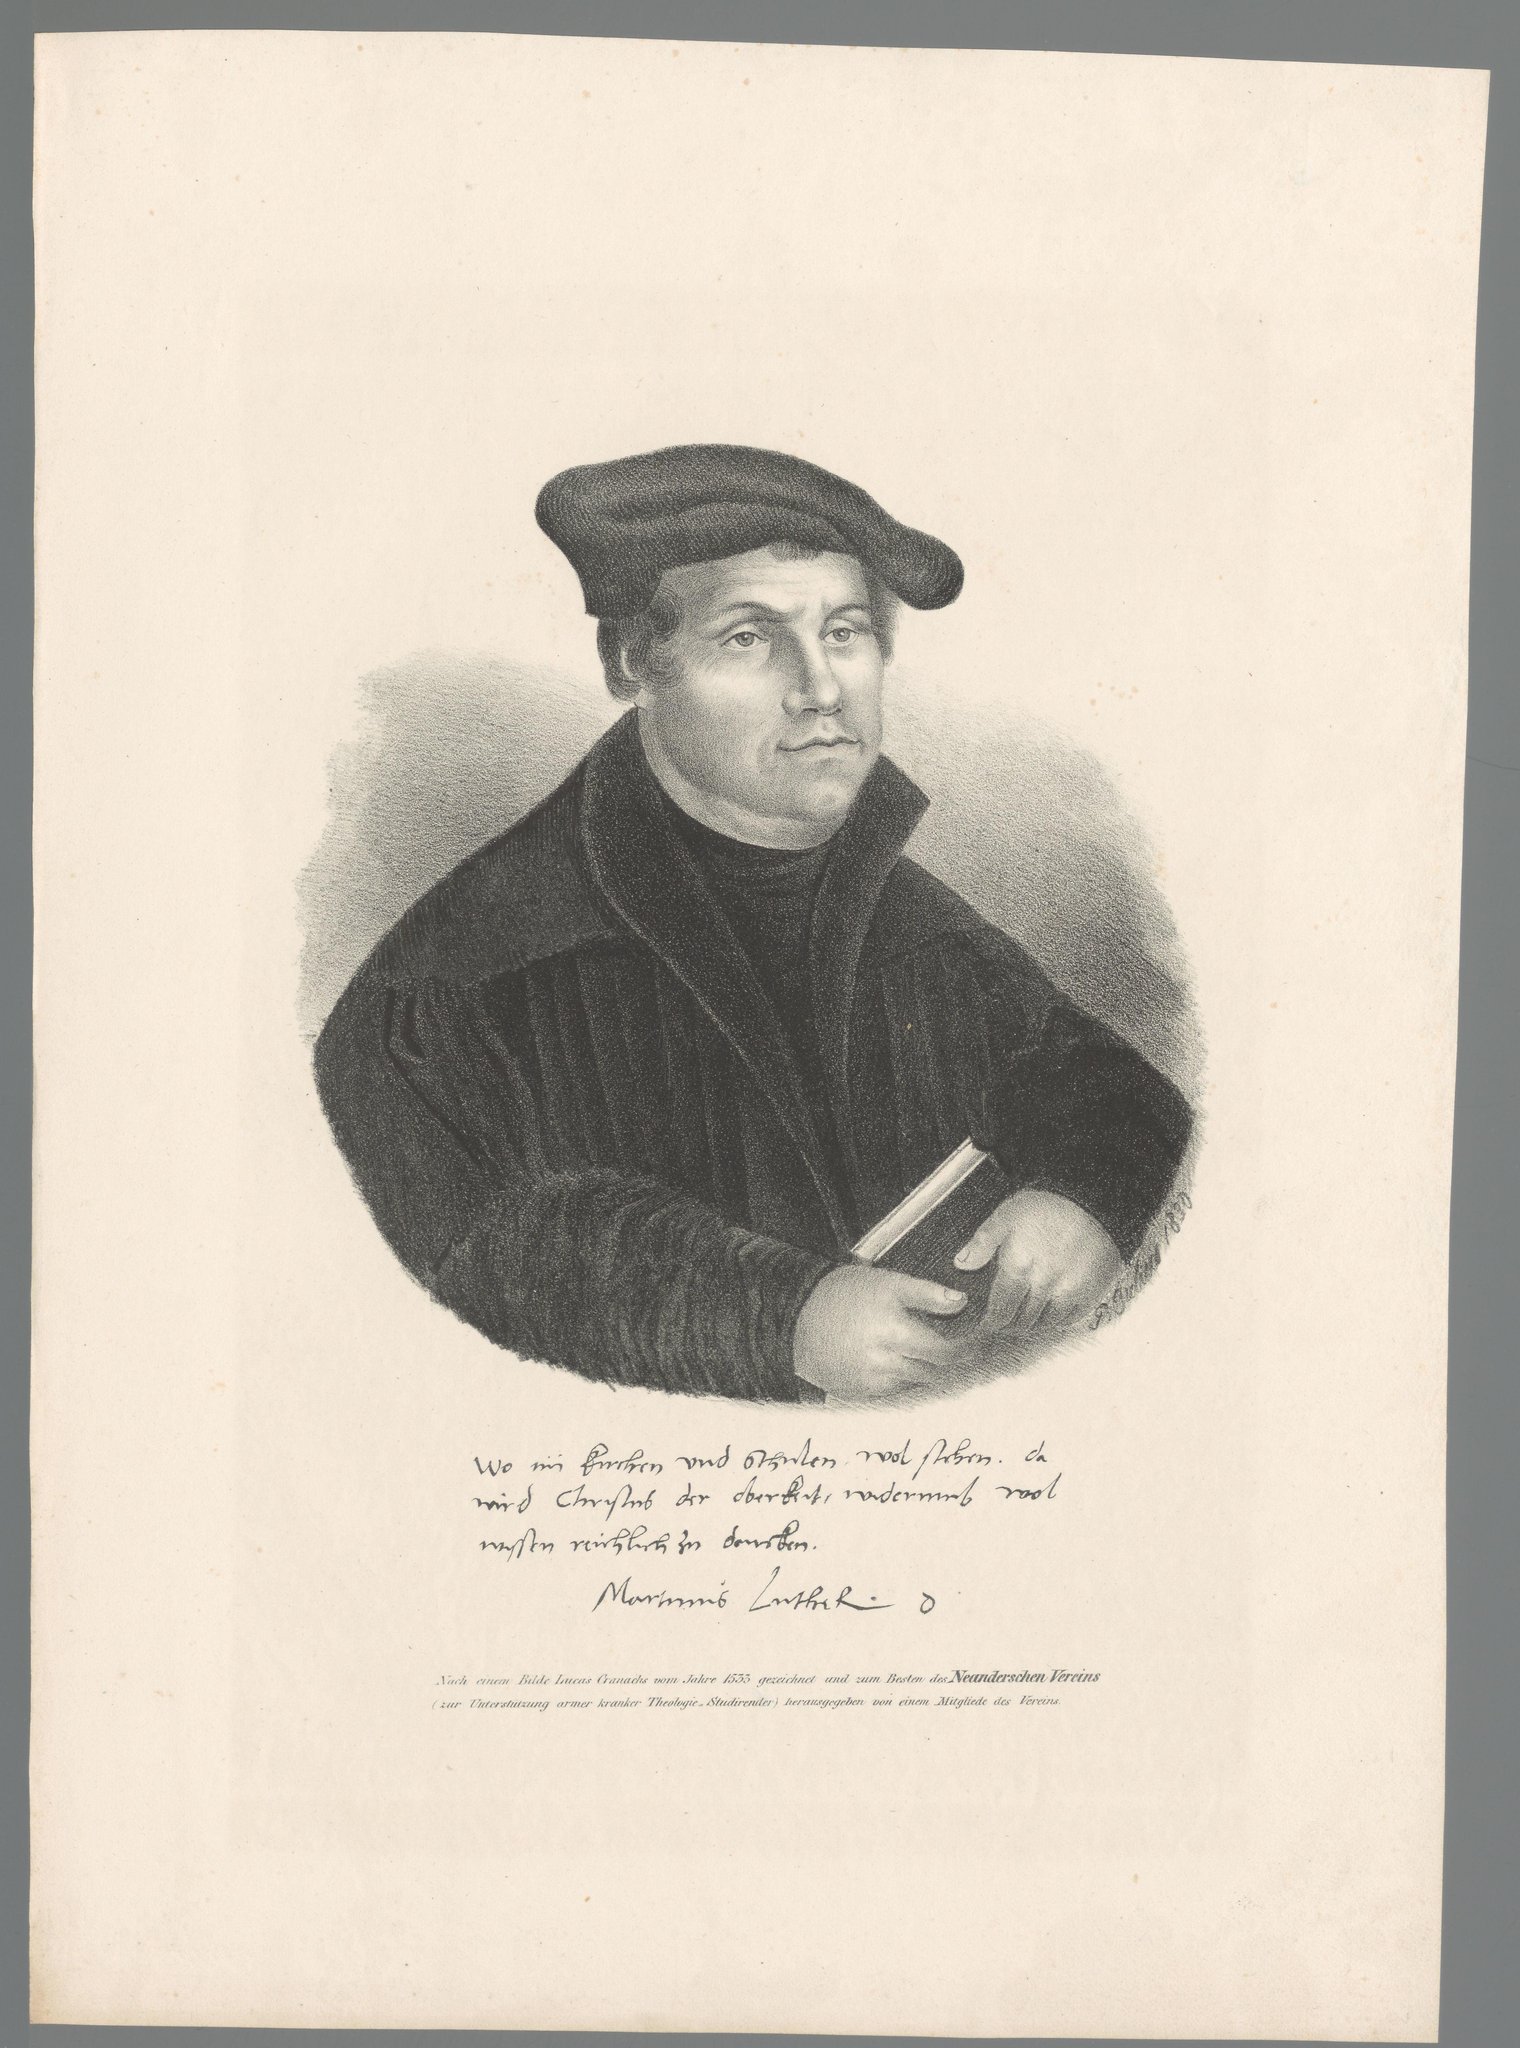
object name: print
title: Portret van Martin Luther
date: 1830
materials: paper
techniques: lithograph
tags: martin luther, adult man, historical persons, the bible as a book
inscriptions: date